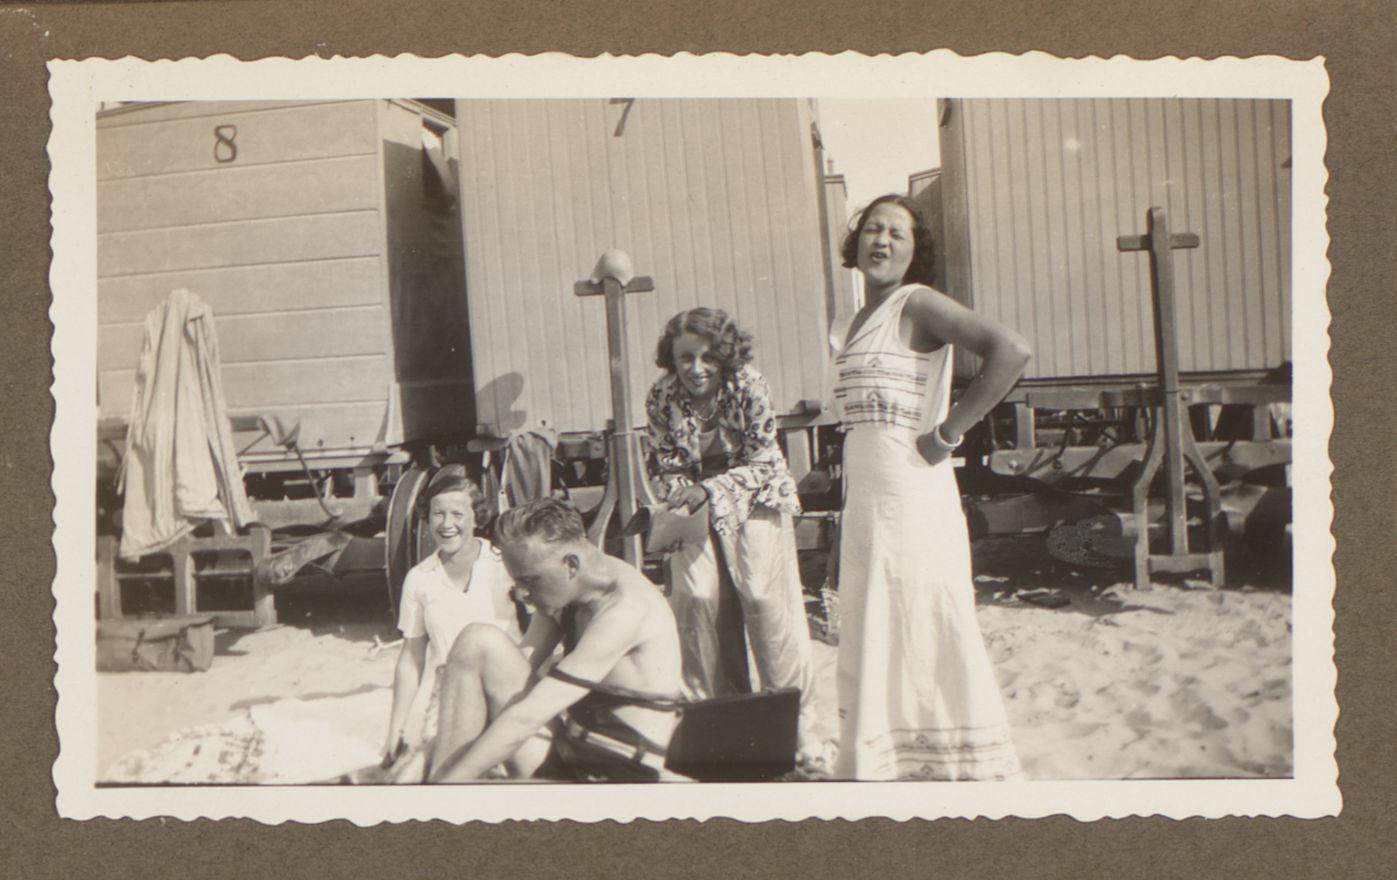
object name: photograph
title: Gezelschap op het strand van Scheveningen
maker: Anonymous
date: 1908-1932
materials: paper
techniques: gelatin silver print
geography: scheveningen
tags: the hague, wilhelmina van zijll de jong, sunbathing (on the beach)